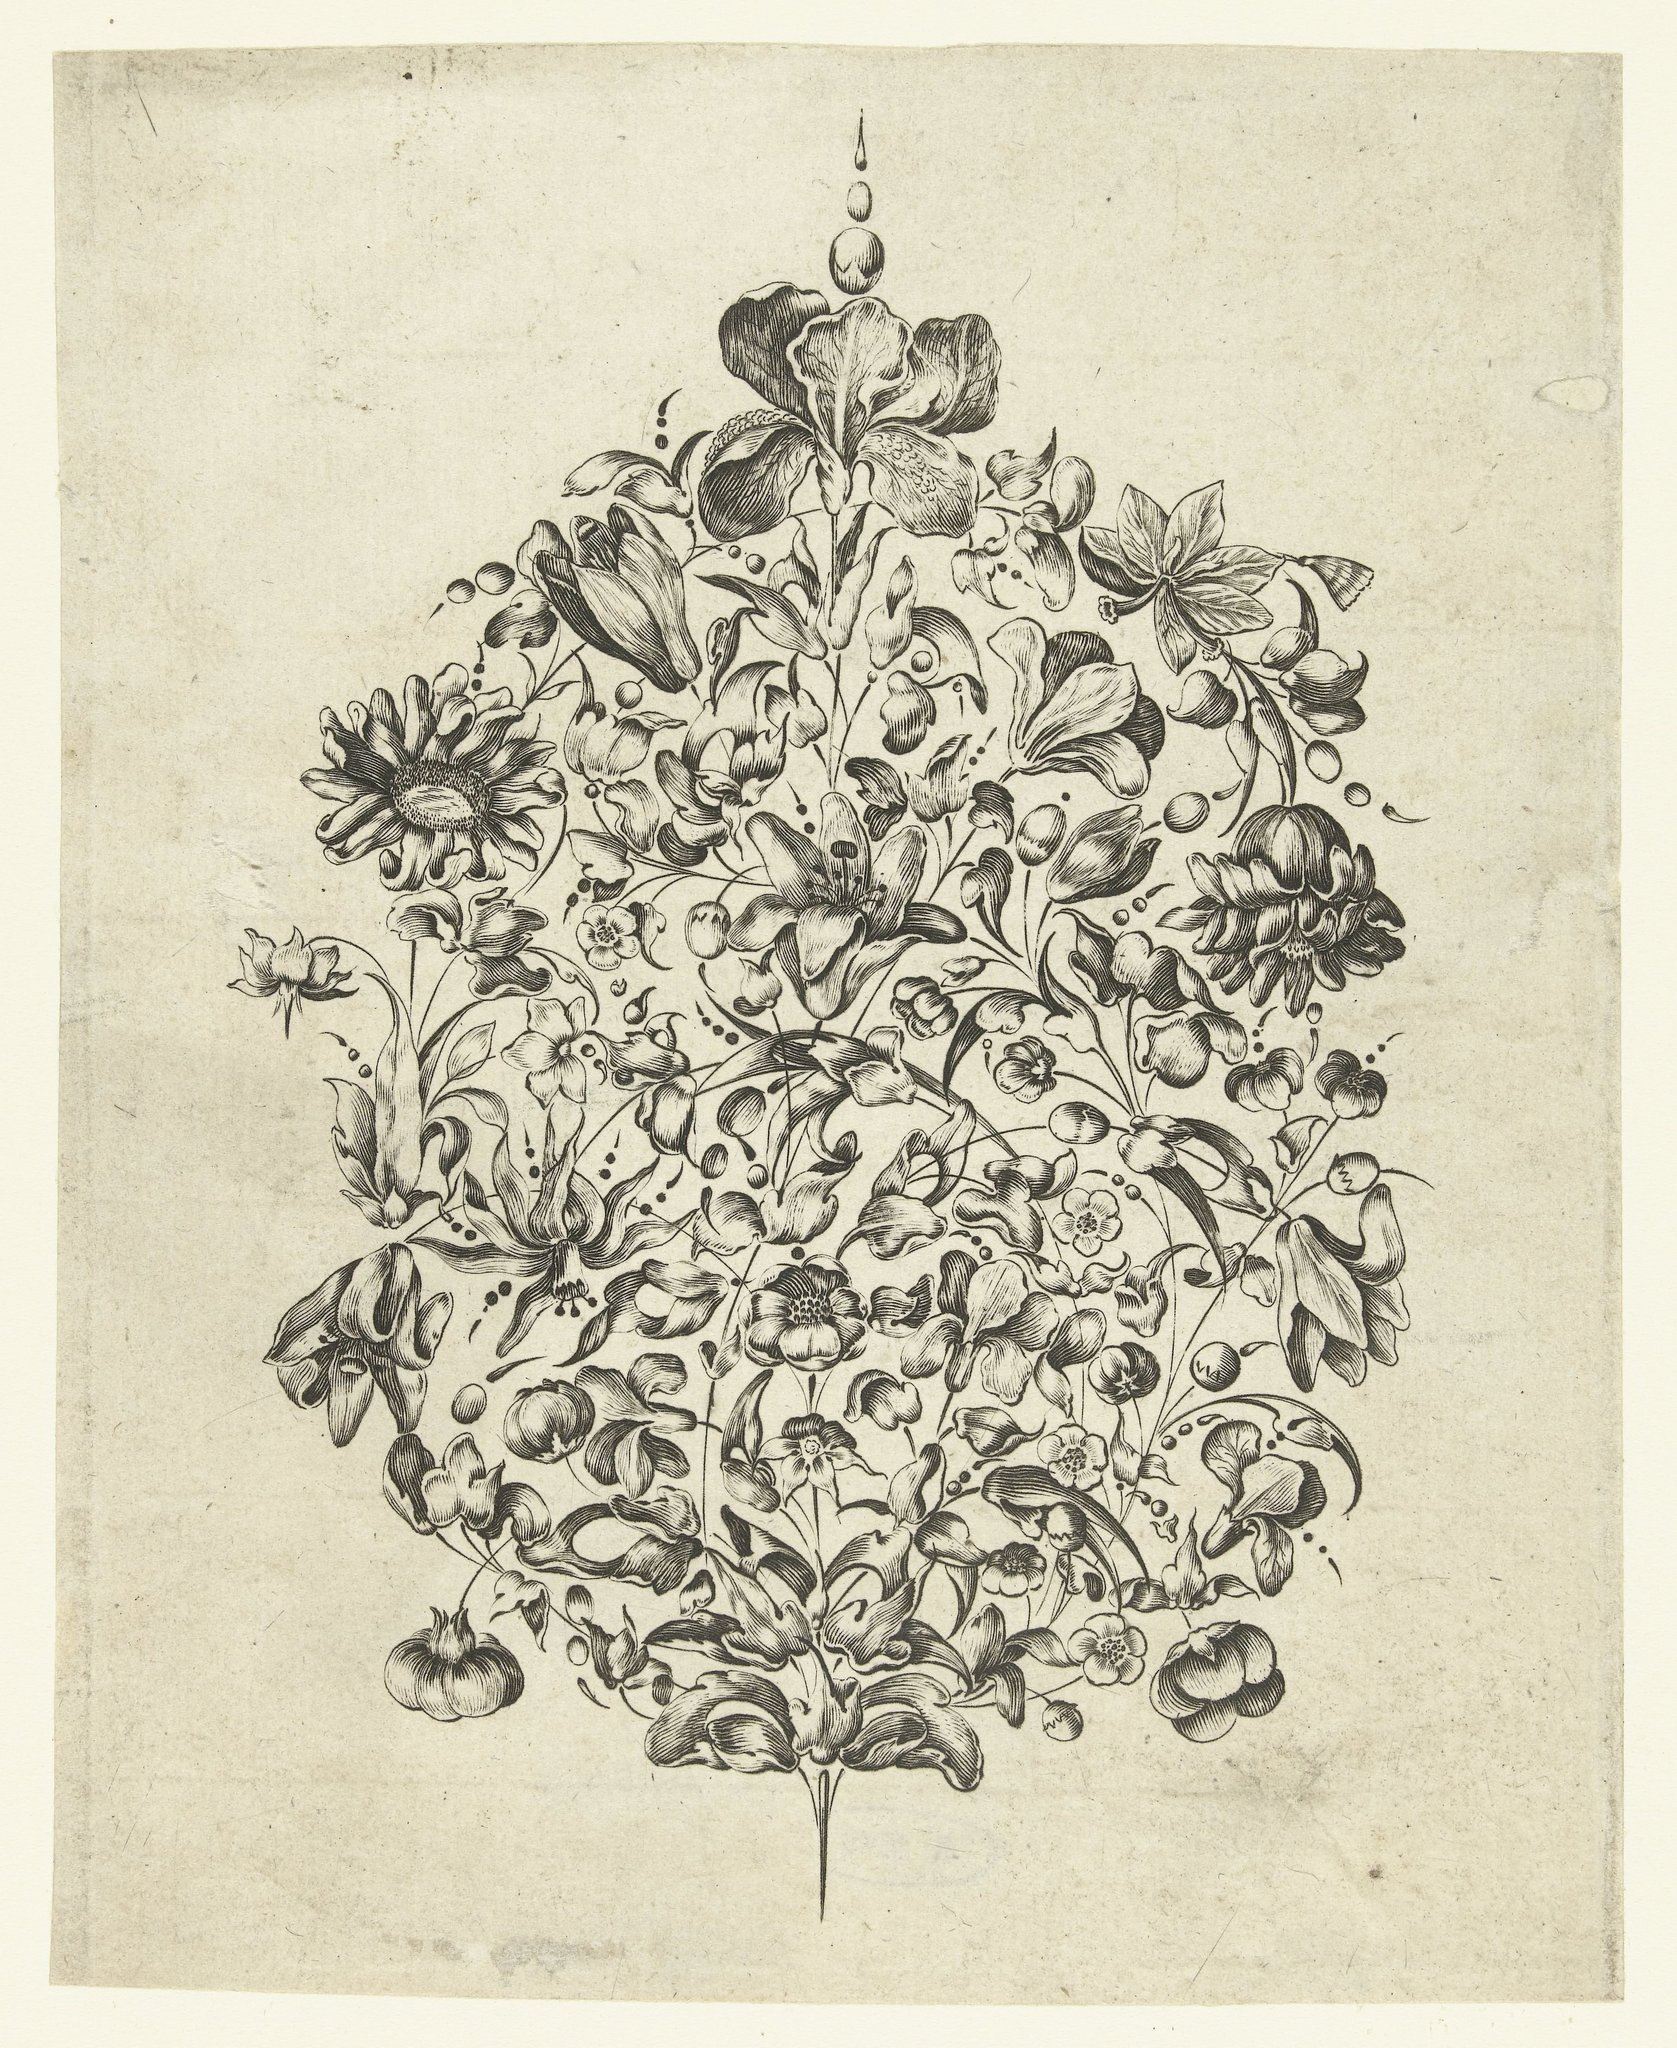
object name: print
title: Livre de Fleurs & de Feuilles pour servir a l'art d'orfevrerie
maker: salomon savery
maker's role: print maker, publisher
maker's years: 1594-1683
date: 1639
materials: paper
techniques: engraving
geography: amsterdam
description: Met in het midden een lelie en bovenaan een iris. Blad komt mogelijk uit de tweede of derde editie van serie boeketten voor goud- en zilversmeden.